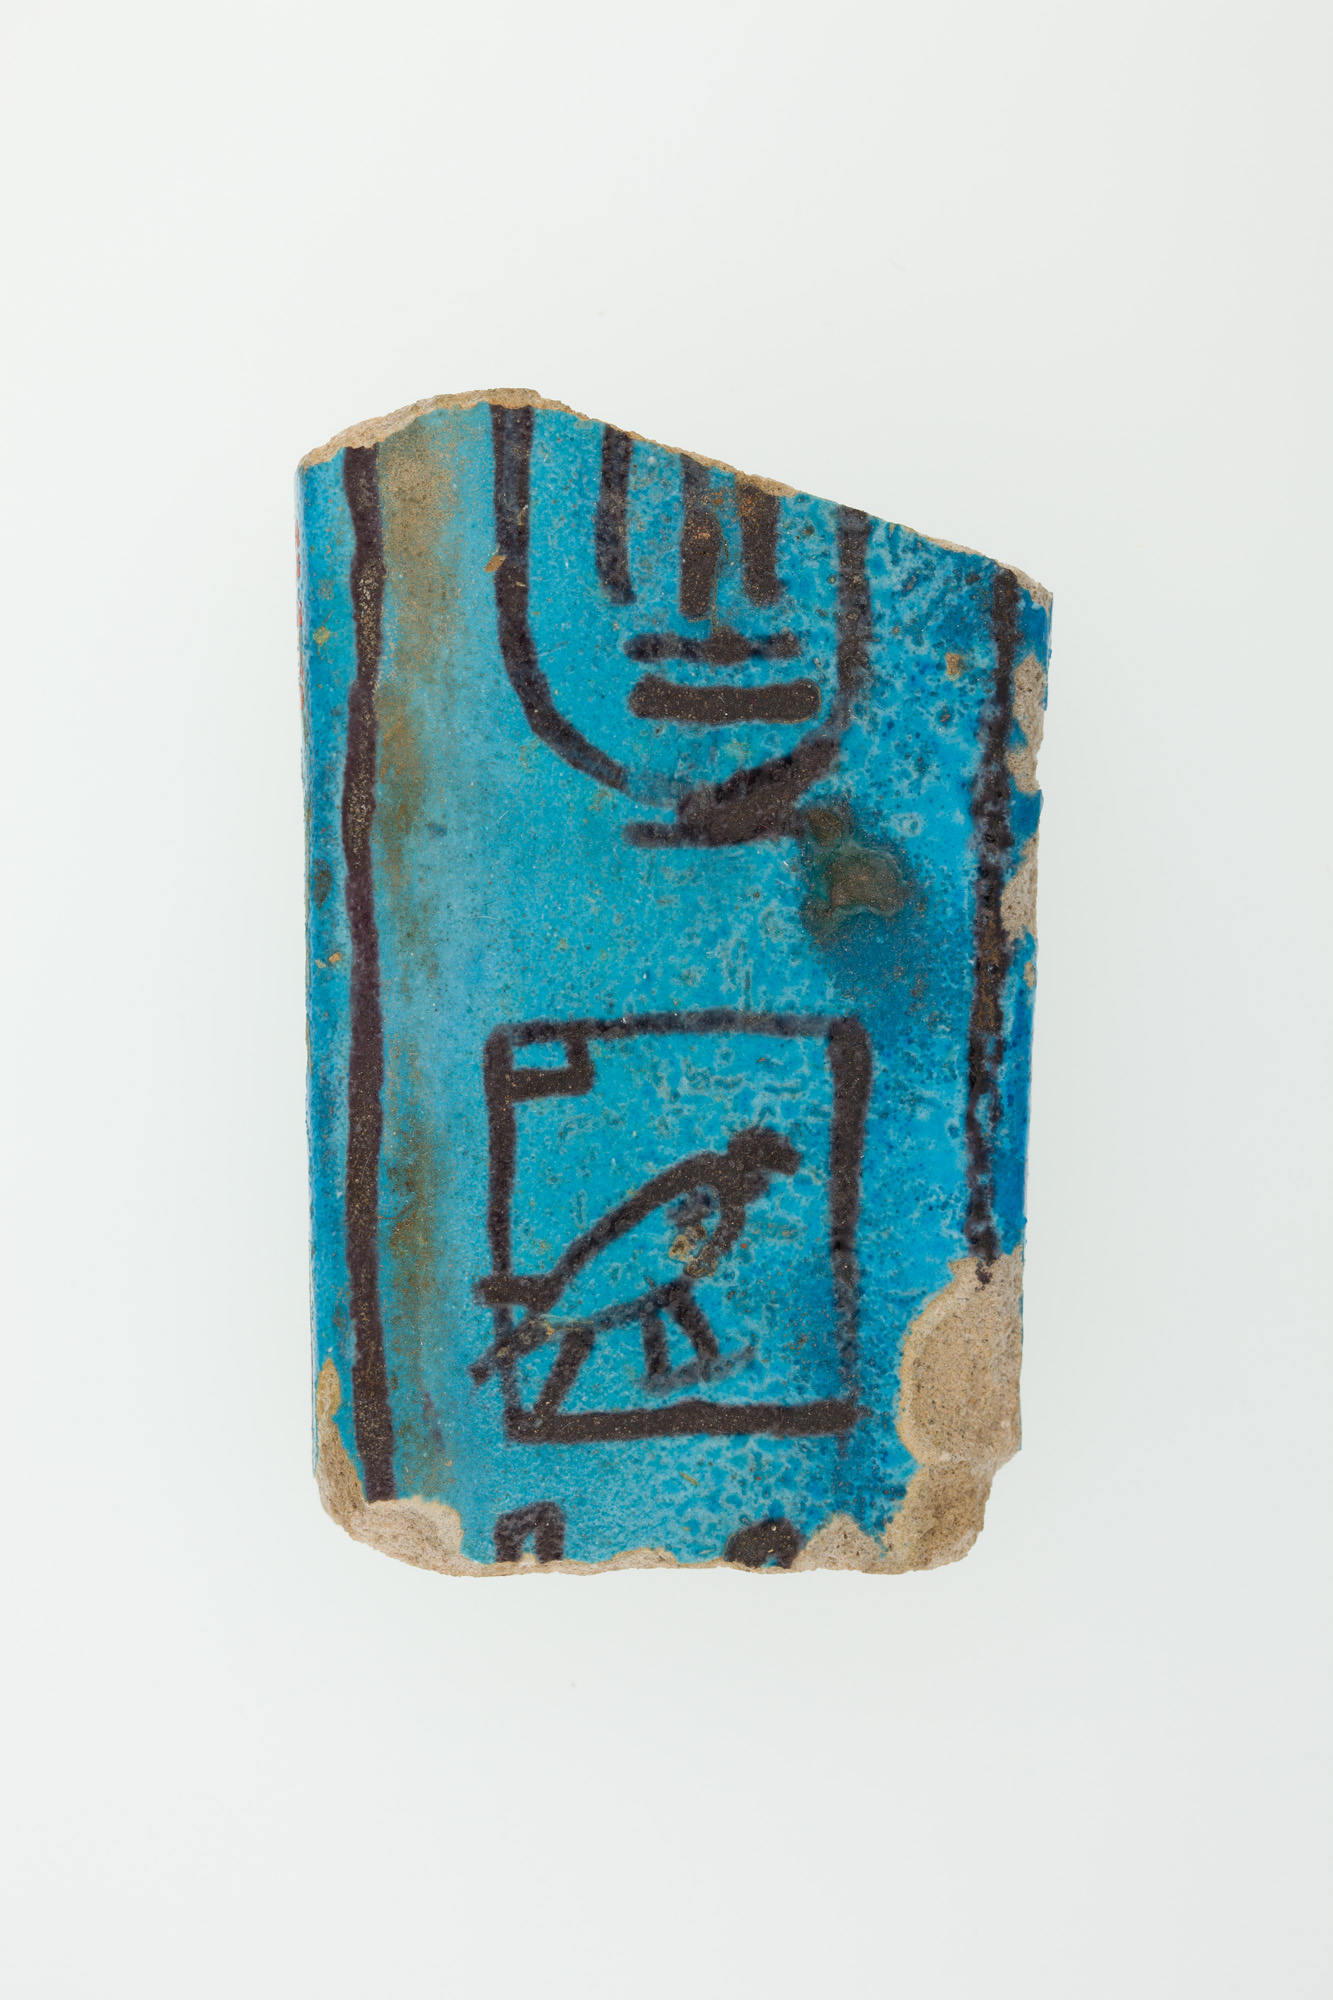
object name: menat fragment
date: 1479-1458 BCE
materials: faience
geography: egypt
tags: hieroglyphs